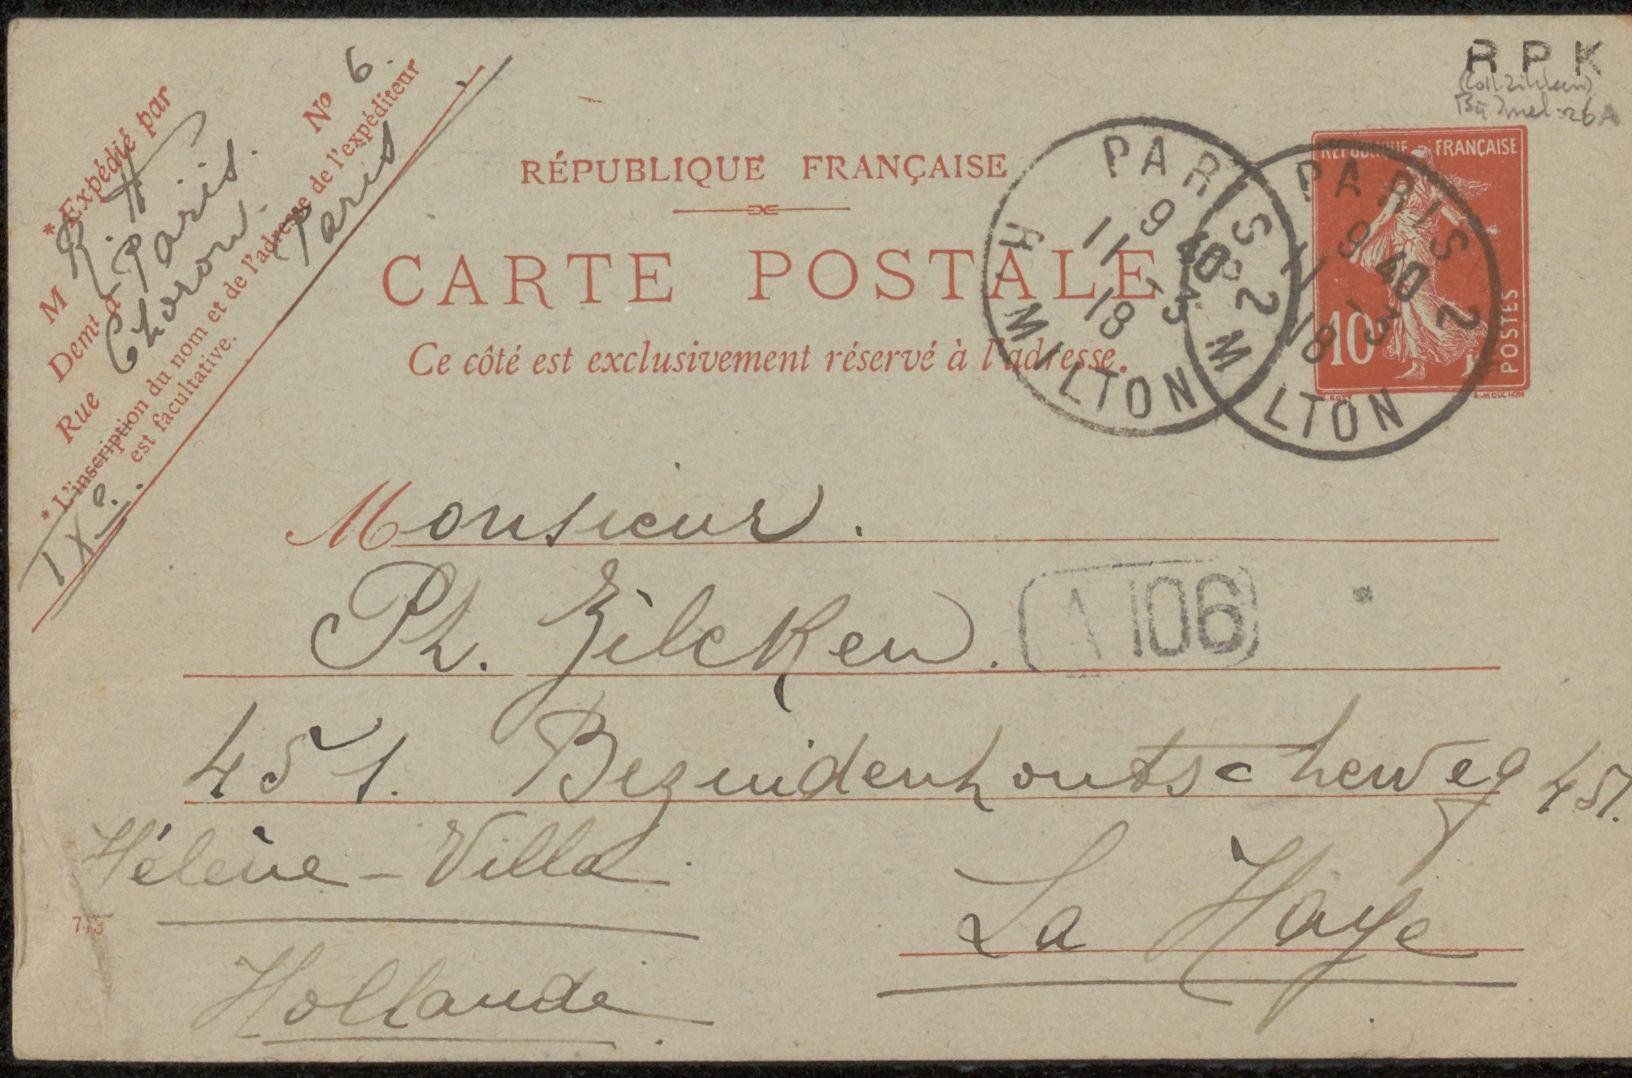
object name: postcard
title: Briefkaart aan Philip Zilcken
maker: rose imel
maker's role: draughtsman, painter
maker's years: 1901-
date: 1919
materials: cardboard, ink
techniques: pen, writing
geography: paris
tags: the hague, painter, draughtsman, philip zilcken, diseases, paris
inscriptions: collector's mark: ‘RPK’